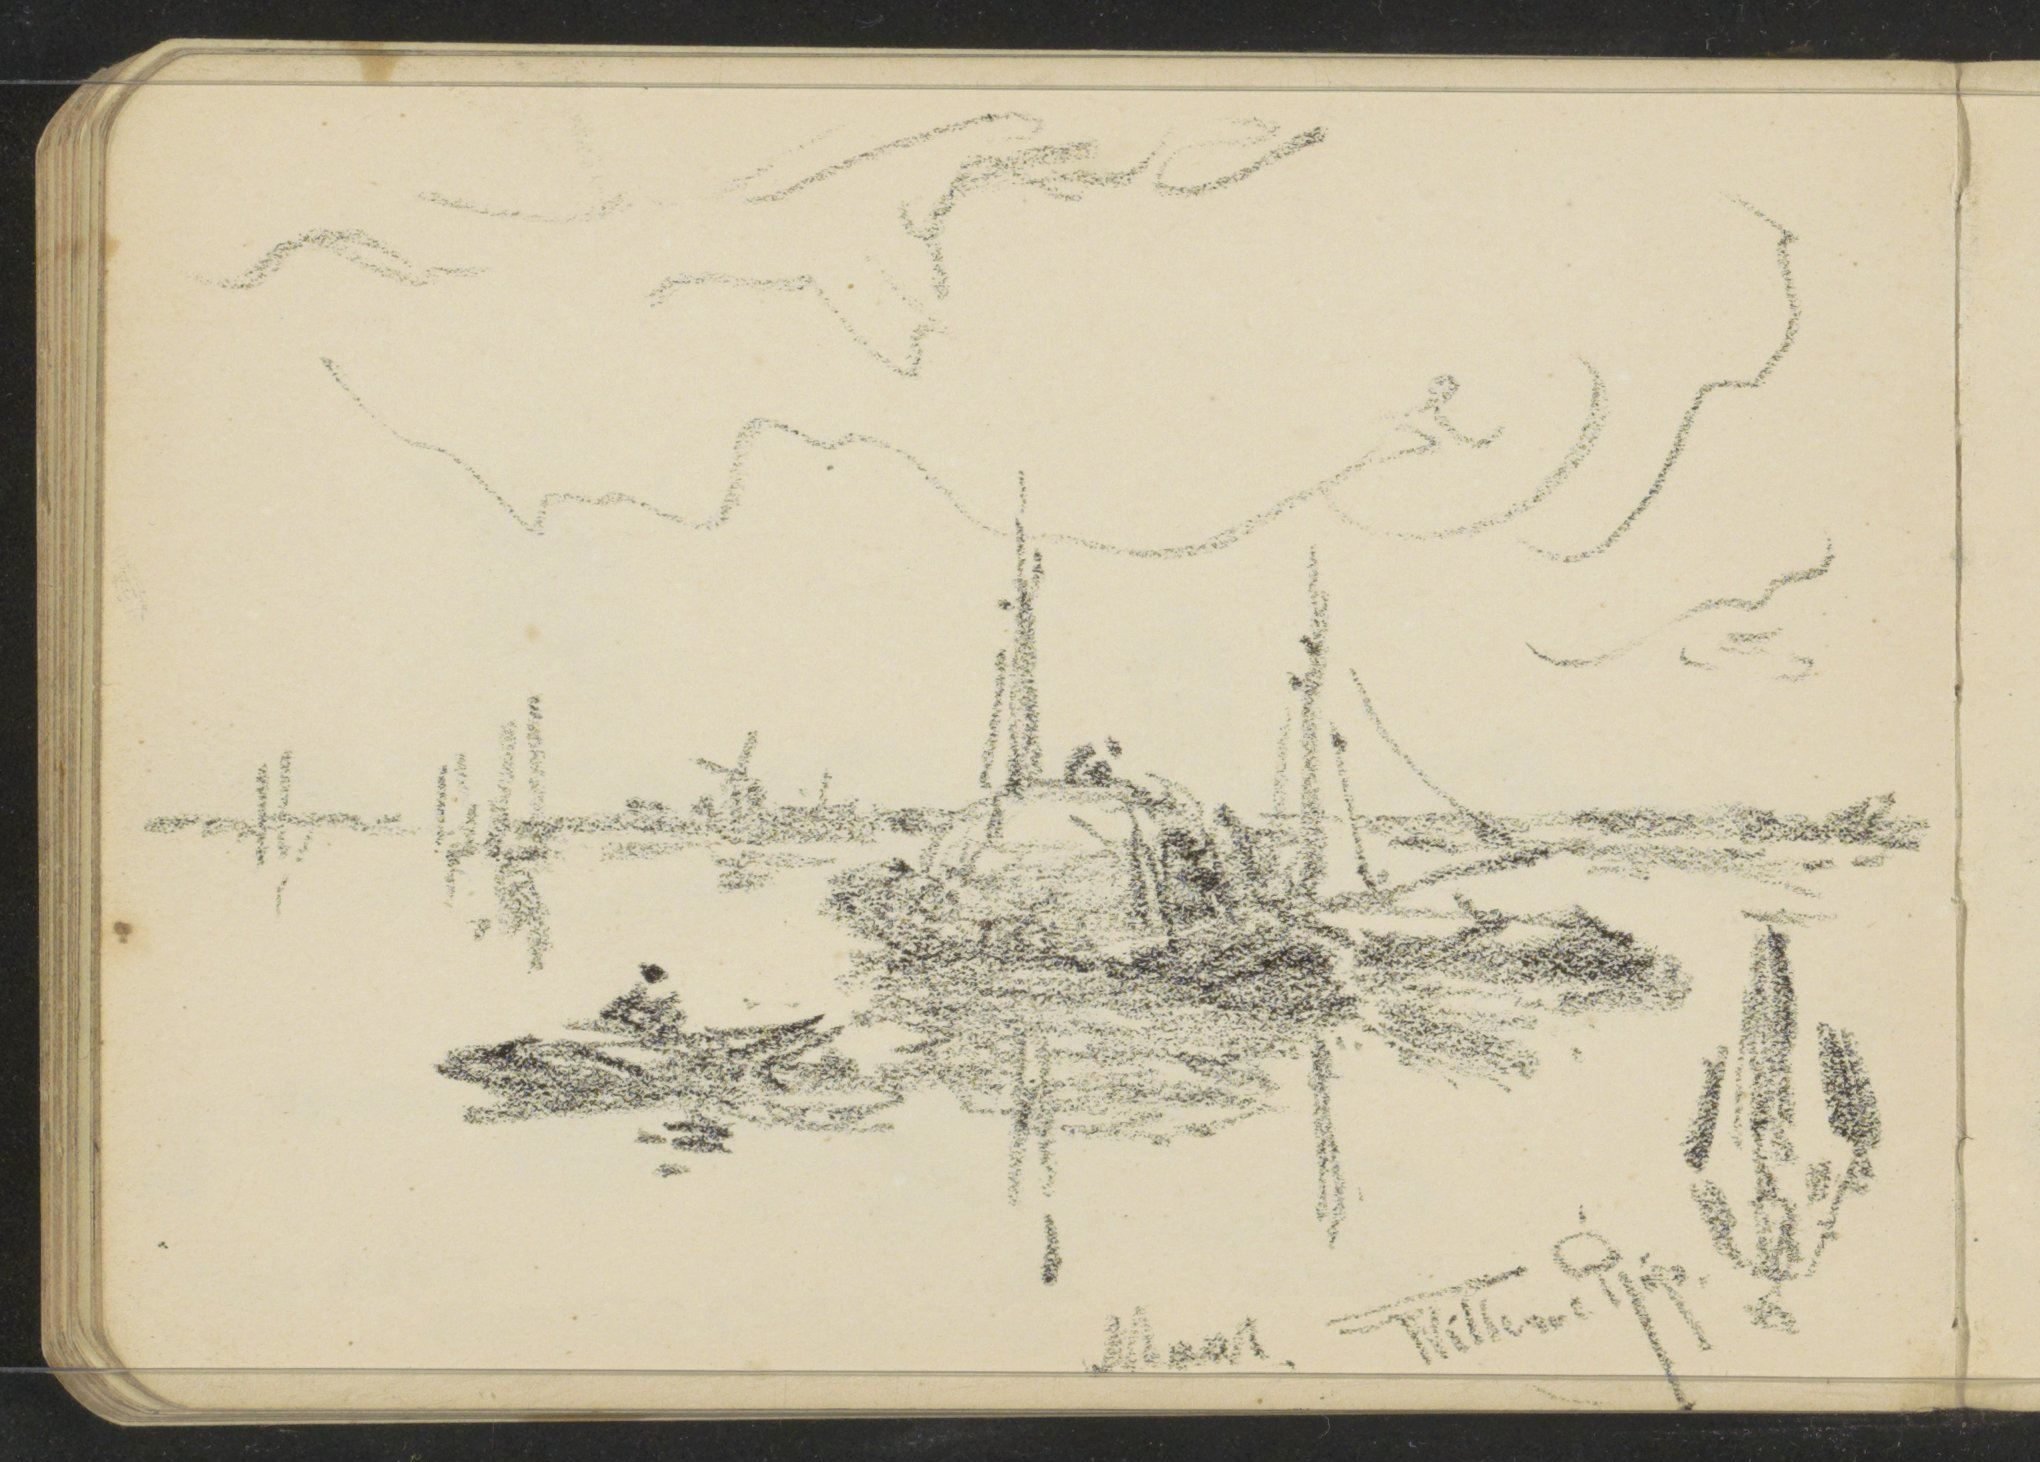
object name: sketchbook leaf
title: Zeilboten op de Maas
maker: willem cornelis rip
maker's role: draughtsman, painter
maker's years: 1856-1922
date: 1914-1916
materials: chalk, paper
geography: meuse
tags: sailing-ship, sailing-boat, river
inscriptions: signature: ‘Willem c Rip’, annotation: ‘Maas’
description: Blad 39 verso uit een schetsboek met 41 bladen.